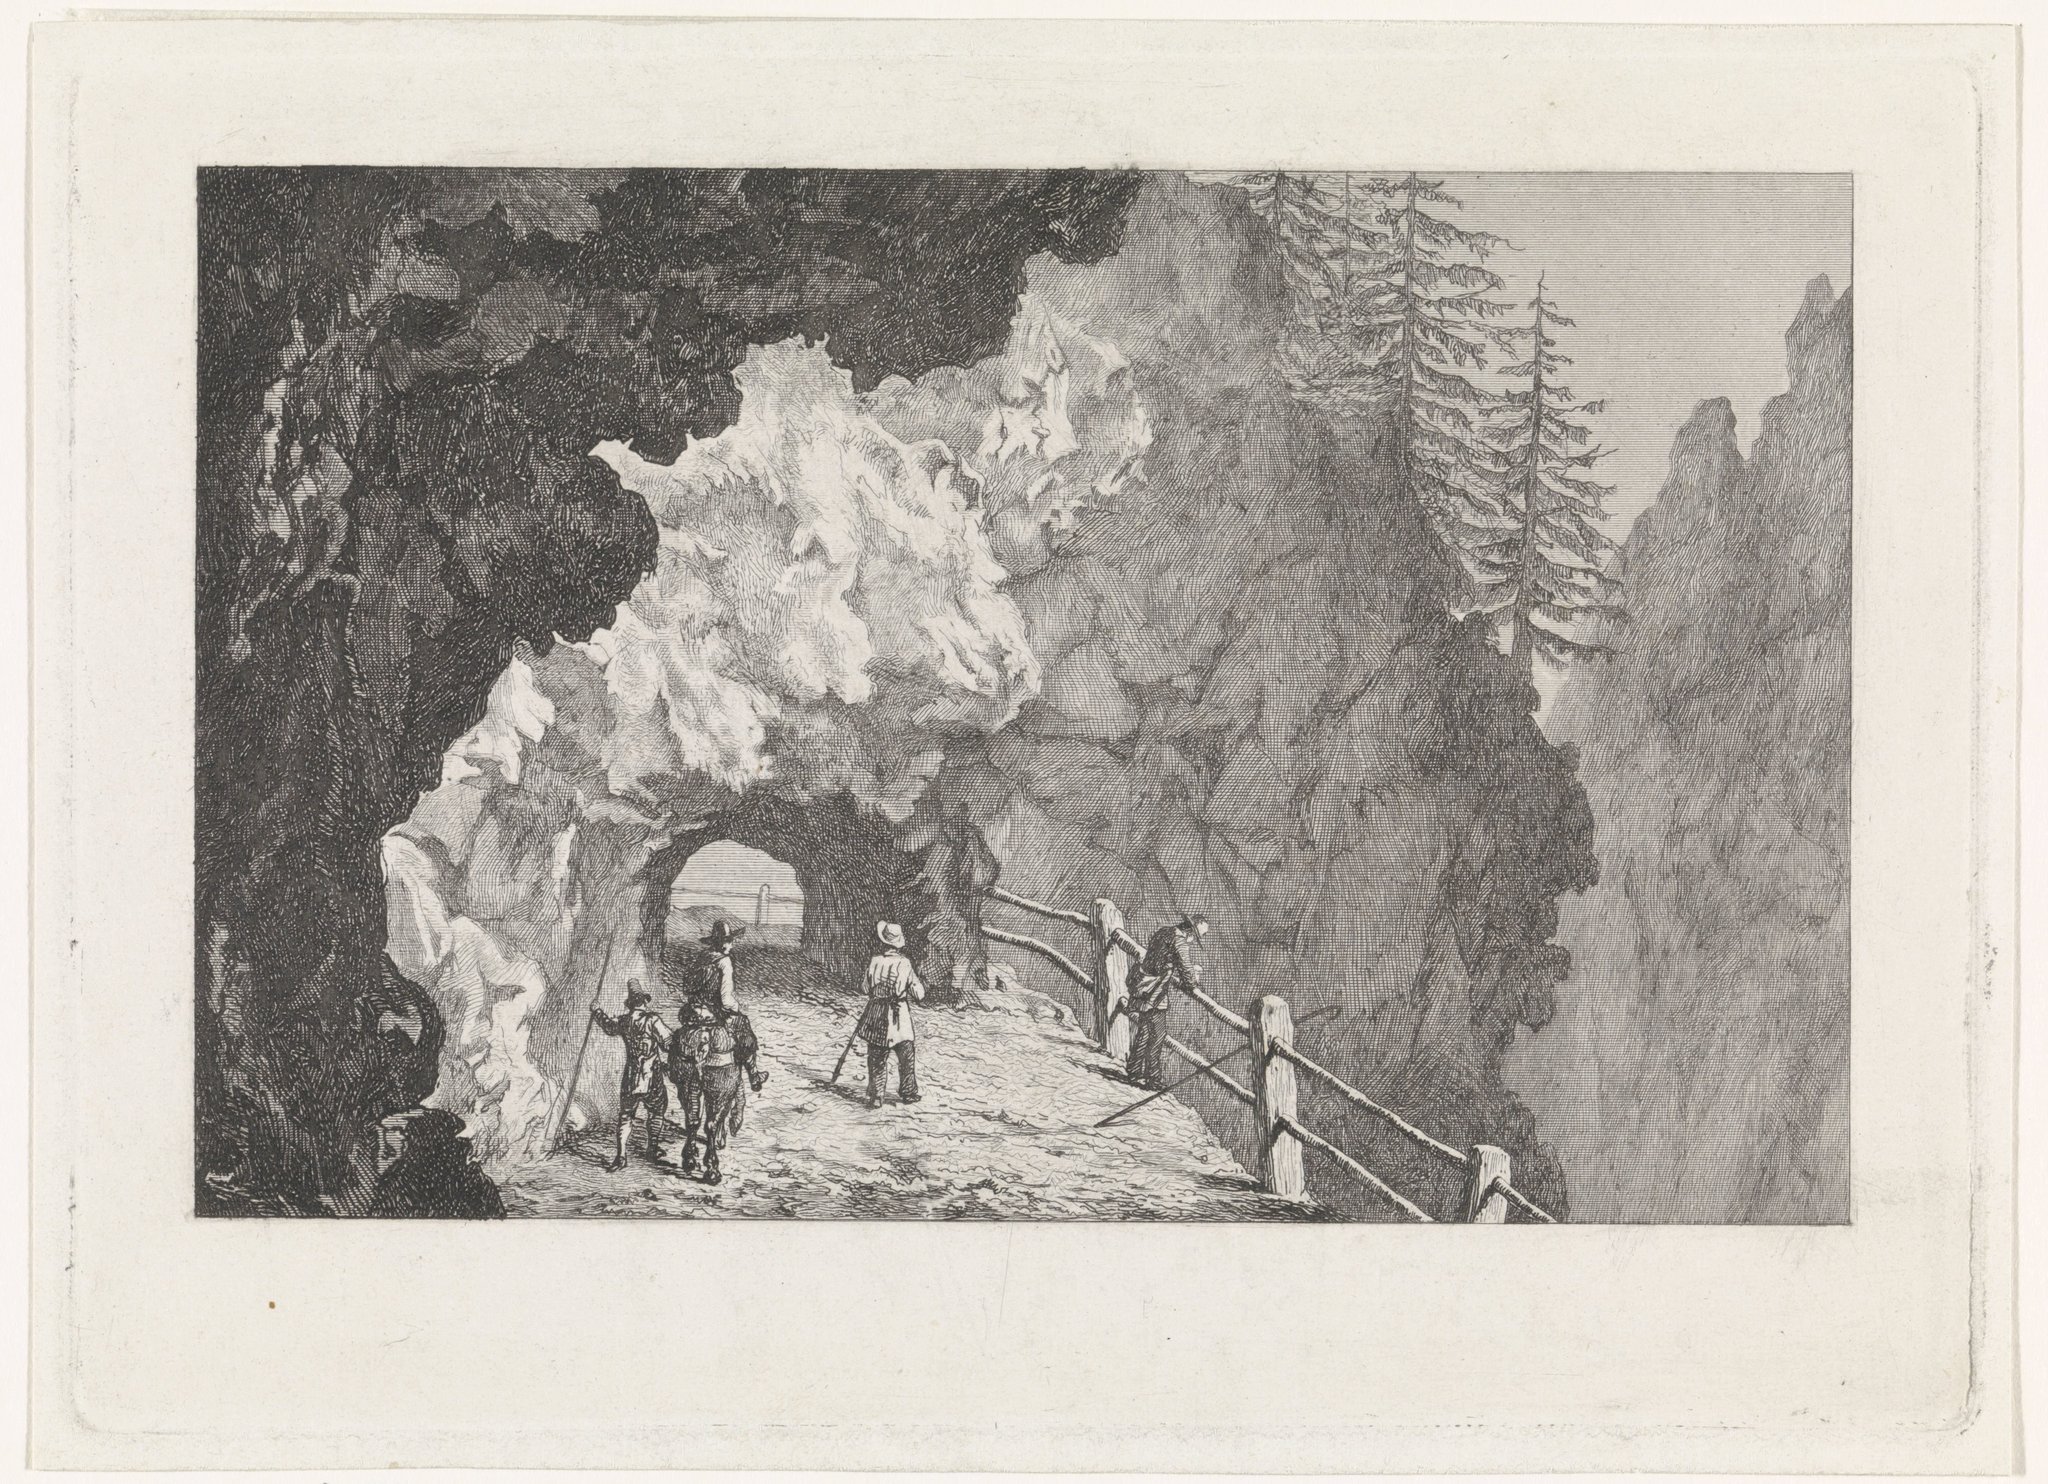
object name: print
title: Doorgang in de rotsen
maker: david van der kellen (1827-1895)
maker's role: draughtsman, print maker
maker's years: 1827-1895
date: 1837-1885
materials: paper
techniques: drypoint, etching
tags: horse, 'en route', traveller under way, rocks, mountains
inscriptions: collector's mark: Lugt 2228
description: Gezicht op een doorgang in de rotsen, met op het bergpad drie voetgangers en een ruiter. Links van de weg een rotswand en rechts een afgrond waar een van de mannen naar beneden staat te kijken.